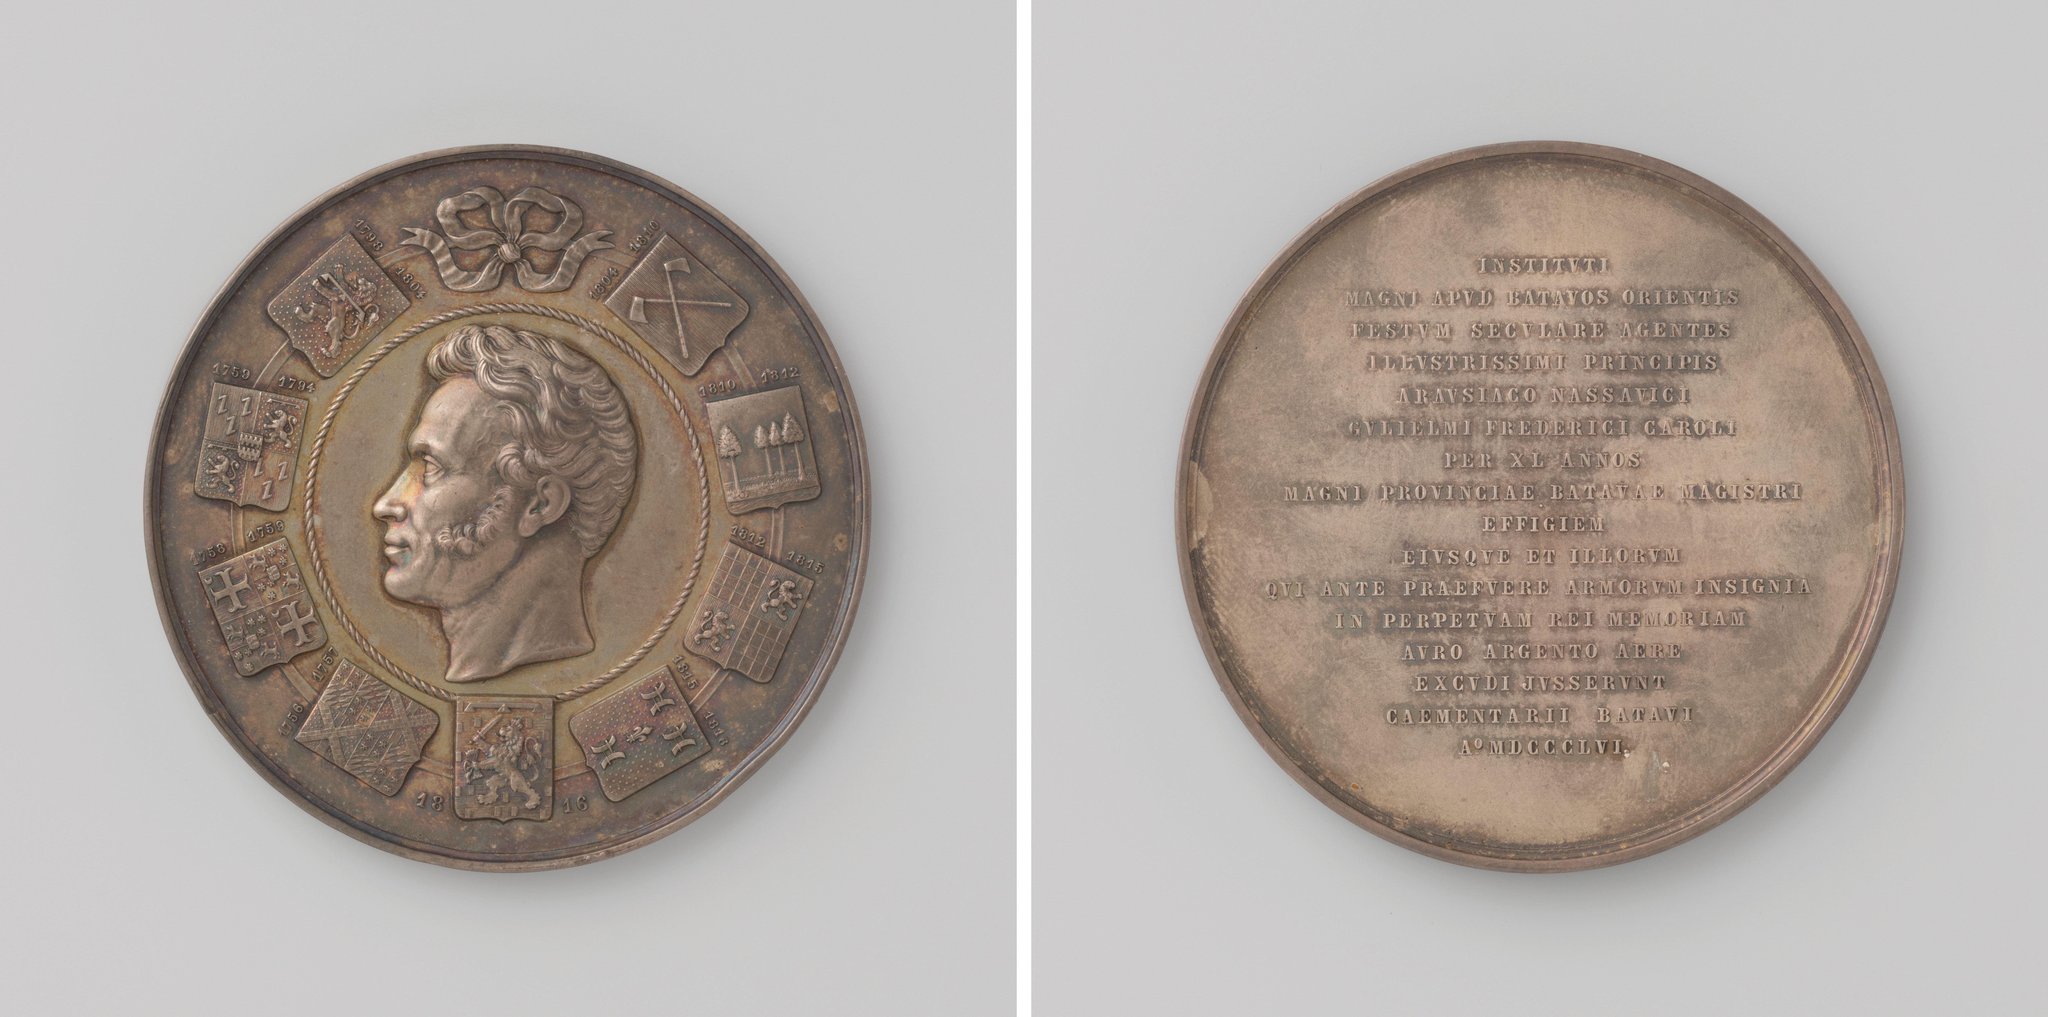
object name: history medal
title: Honderdjarig bestaan van de loge Groot Oosten, ter ere van Frederik, prins der Nederlanden, veertig jaar Grootmeester, penning geslagen op last van de vrijmetselarij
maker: Anonymous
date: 1856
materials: silver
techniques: striking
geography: netherlands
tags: rotterdam, berlin, frederik (prins der nederlanden)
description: Zilveren penning. Voorzijde: borststuk man binnen kabelrand en de negen met lint verbonden wapenschilden van zijn voorgangers. Keerzijde: opschrift.